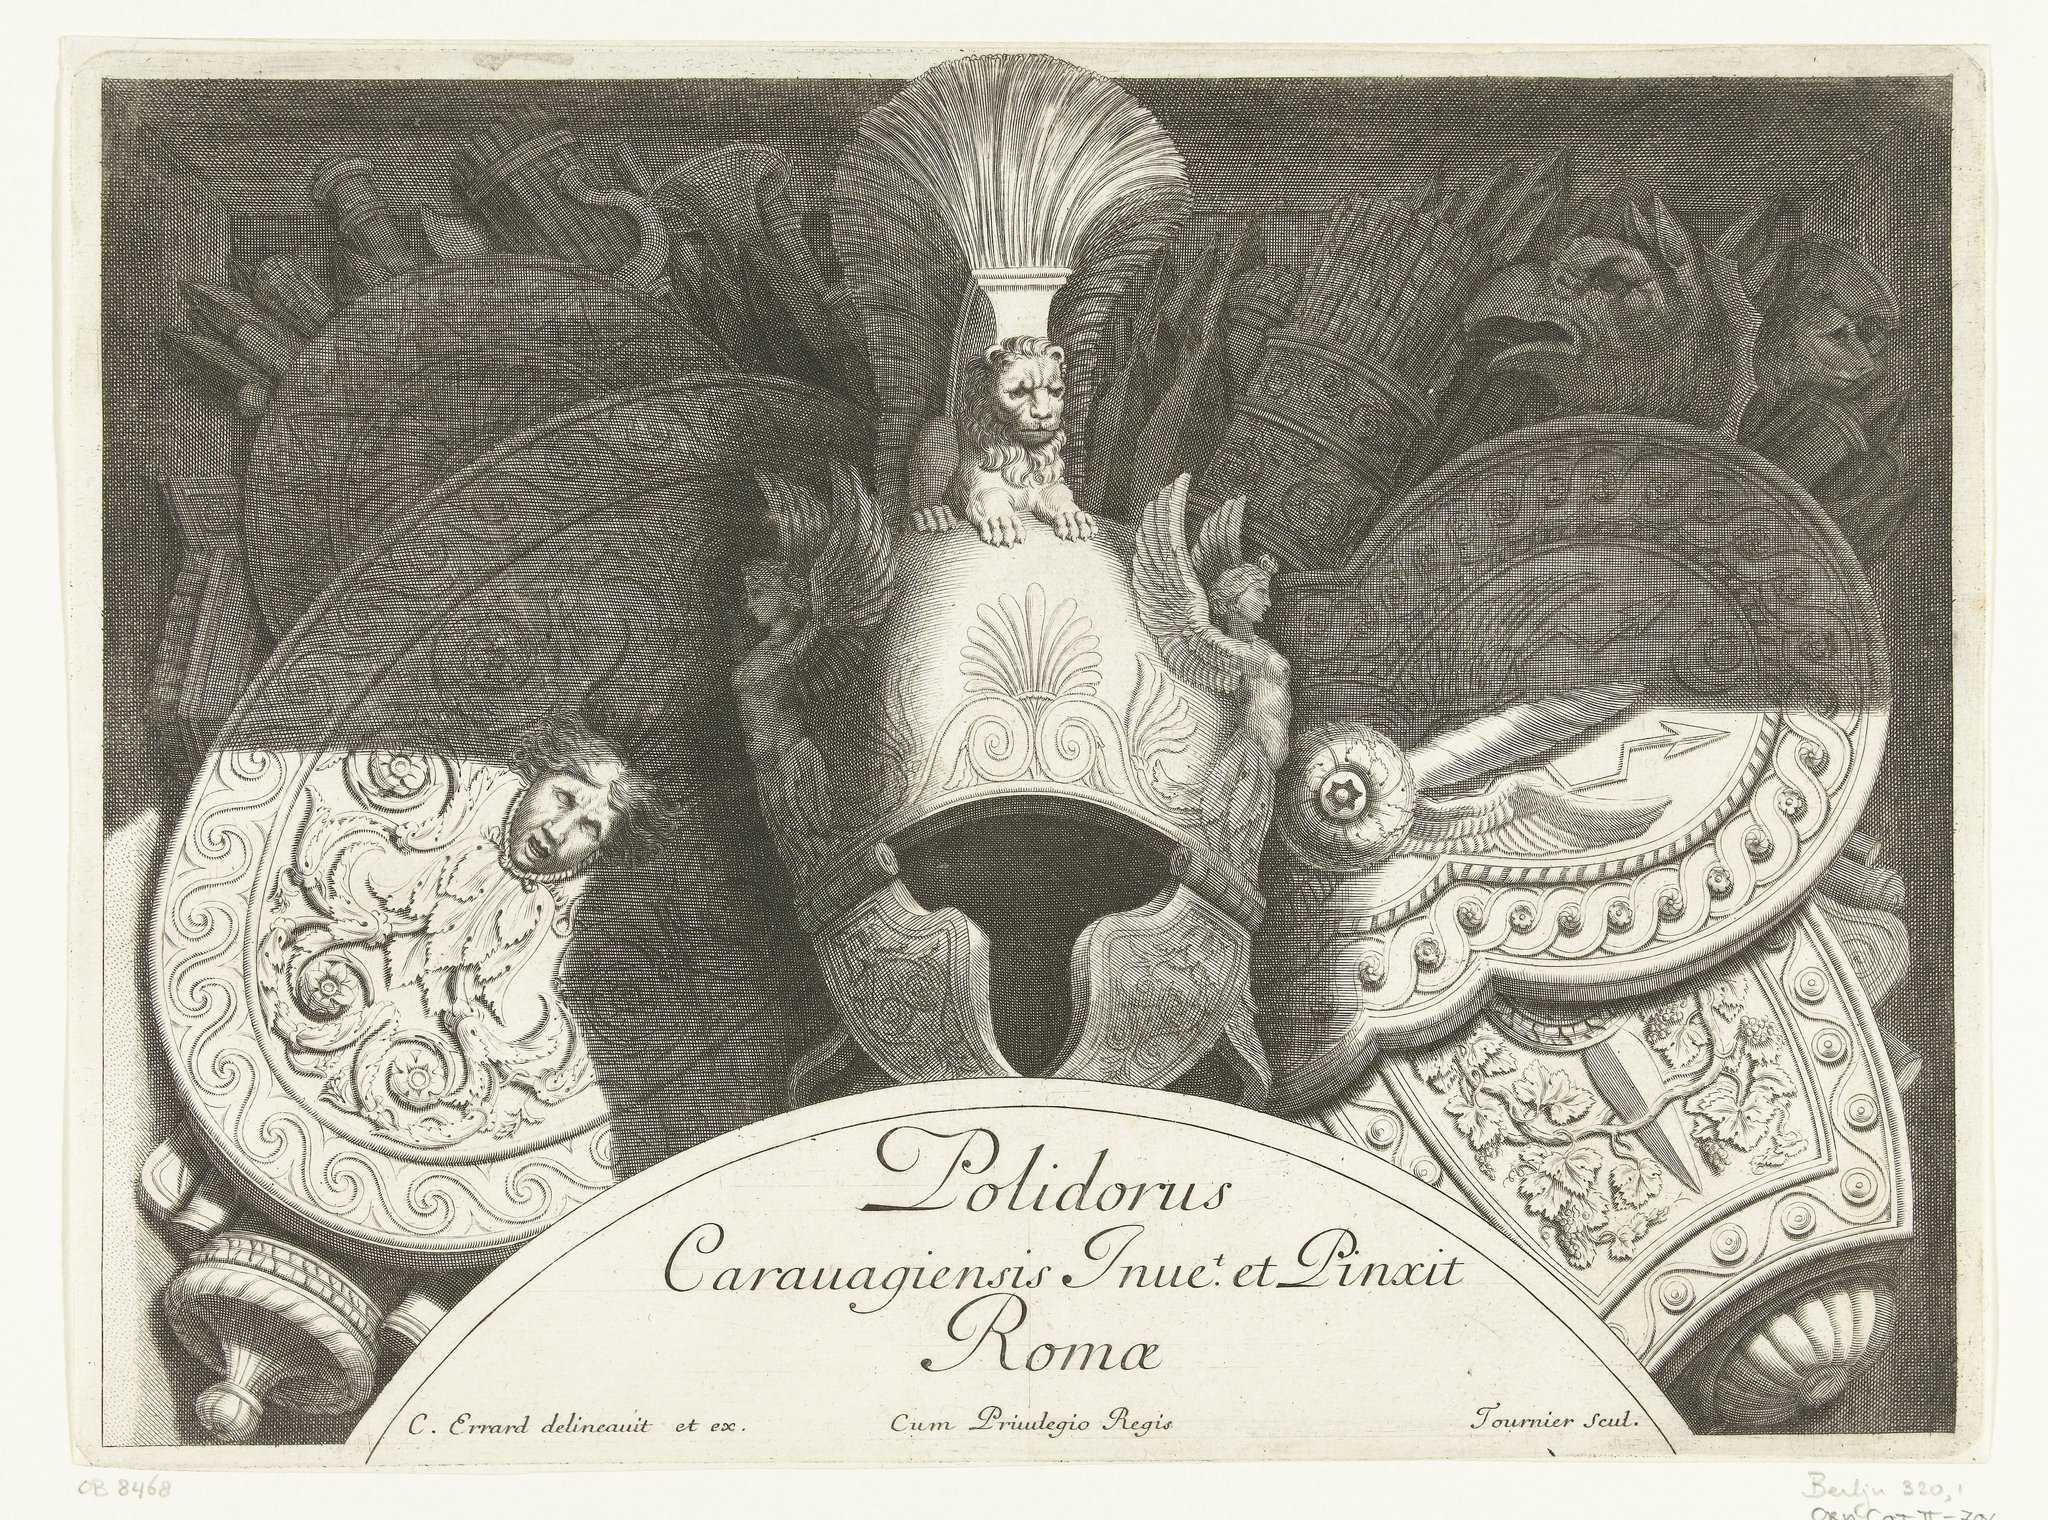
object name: ornament print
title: Divers Trophées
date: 1651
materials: paper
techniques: engraving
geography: paris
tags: helmet, beasts of prey, predatory animals: lion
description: De leeuw draagt de pluim op zijn rug. De zijkanten van de helm zijn gedecoreerd met gevleugelde, naakte vrouwen. Uit serie van titelblad en vijf bladen.